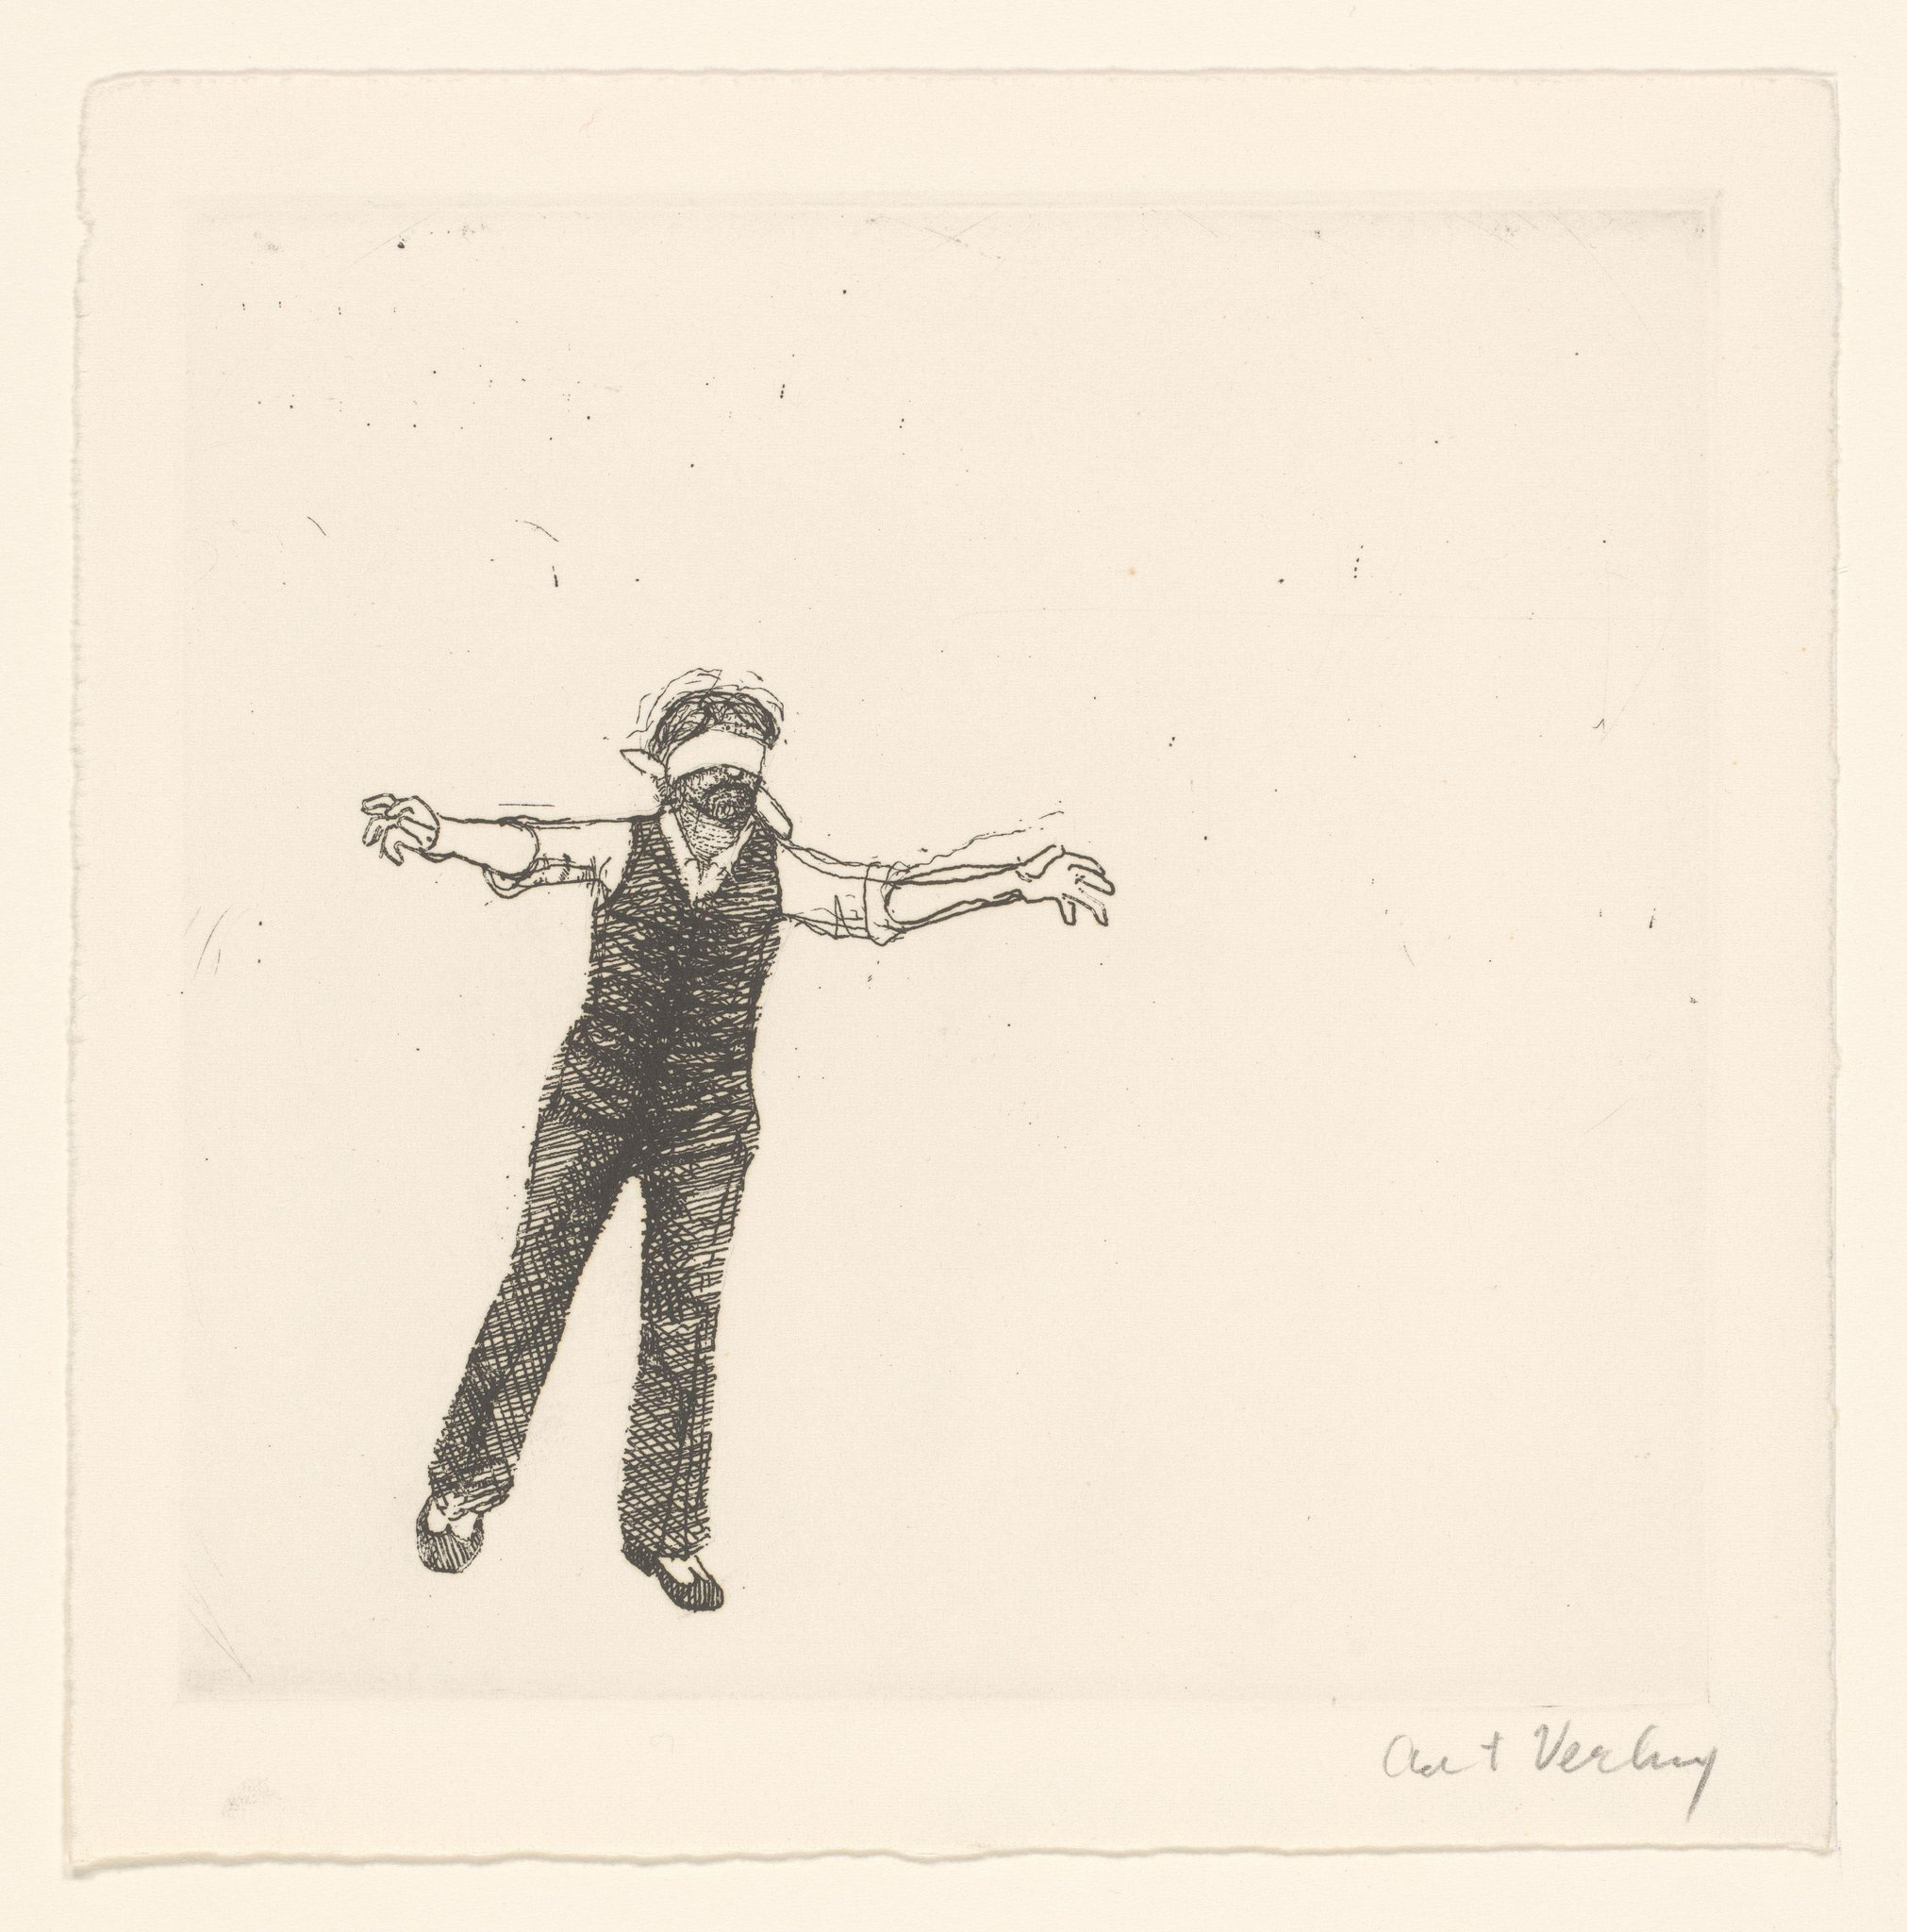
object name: print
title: Geblinddoekte man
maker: aat verhoog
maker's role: print maker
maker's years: 1933-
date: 1965-1980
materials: paper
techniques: etching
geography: amsterdam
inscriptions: signature: ‘Aat Verhoog’